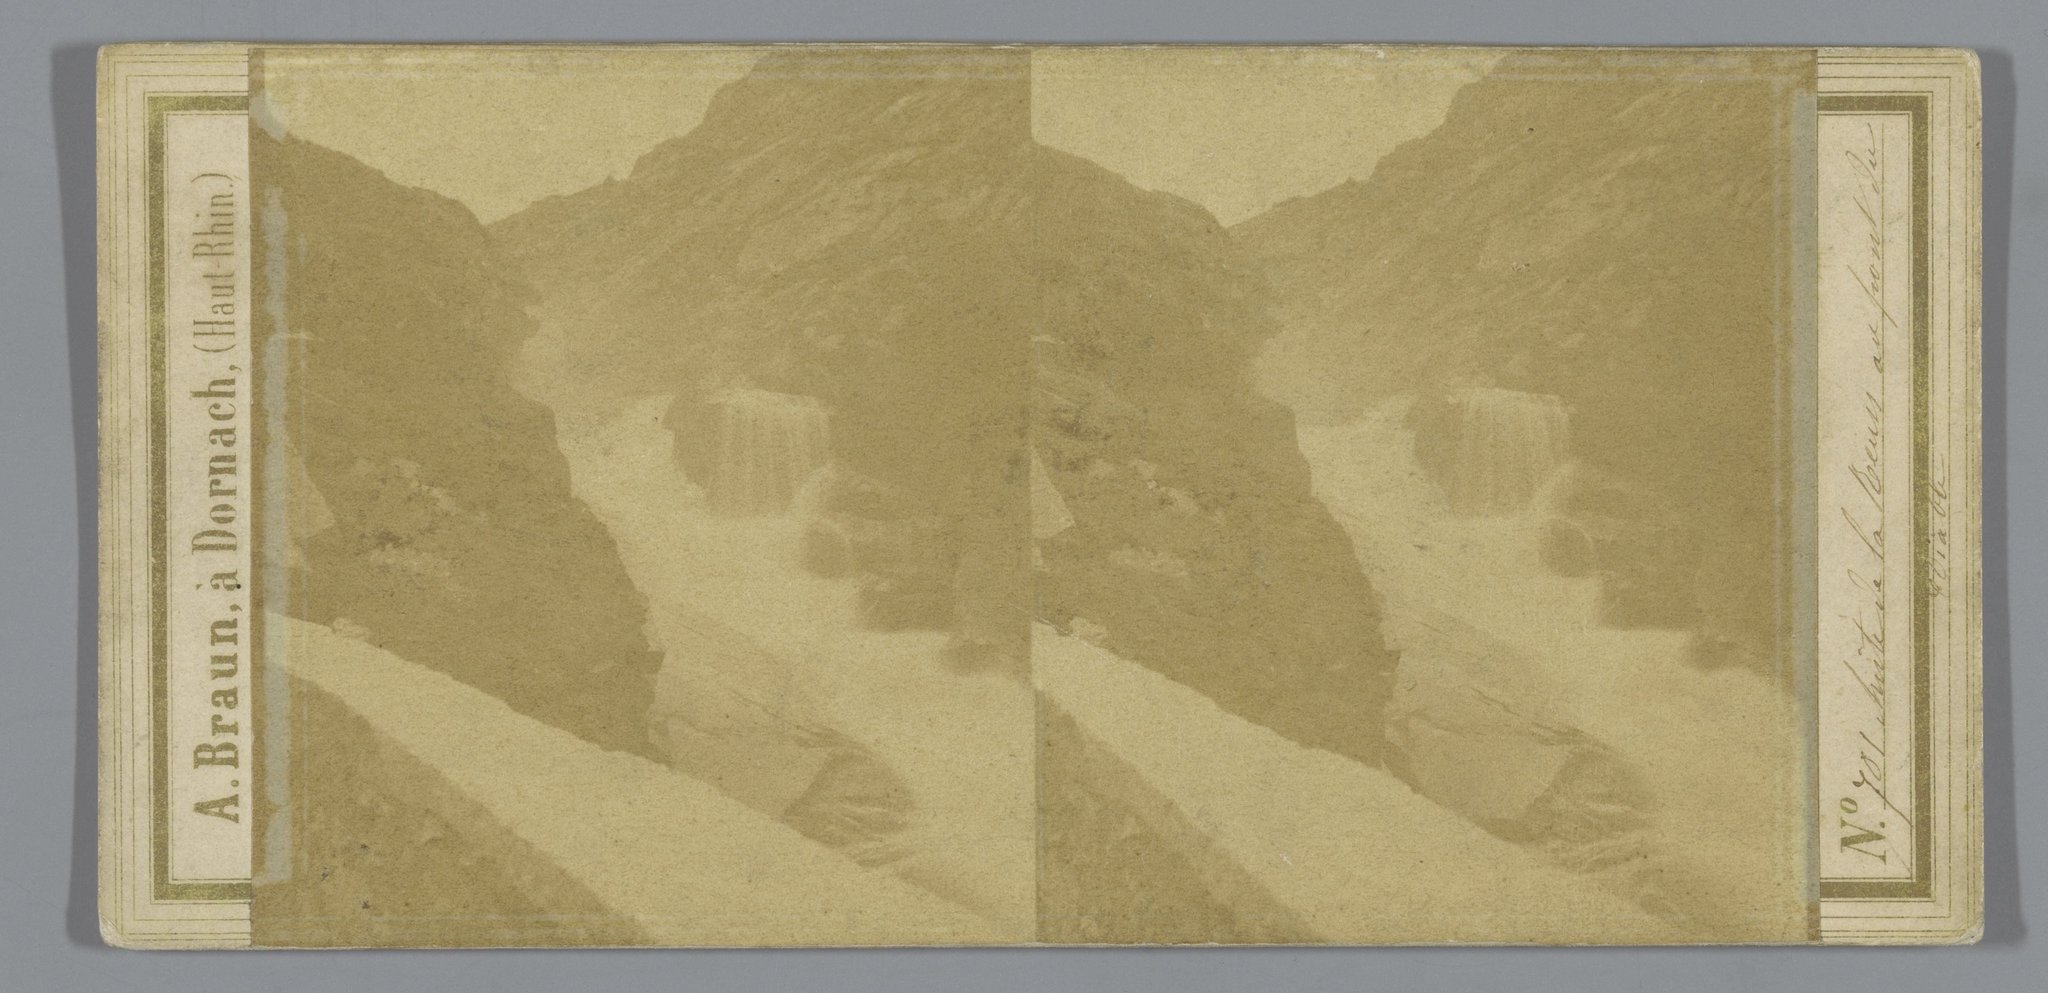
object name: stereograph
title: Gezicht op de bron van de Reuss, Zwitserland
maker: Anonymous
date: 1860-1866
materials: cardboard, paper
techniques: albumen print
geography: dornach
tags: mountain-range, snow peaks, spring, source of river or stream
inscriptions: number: ‘No. 701’, inscription: ‘S/P’